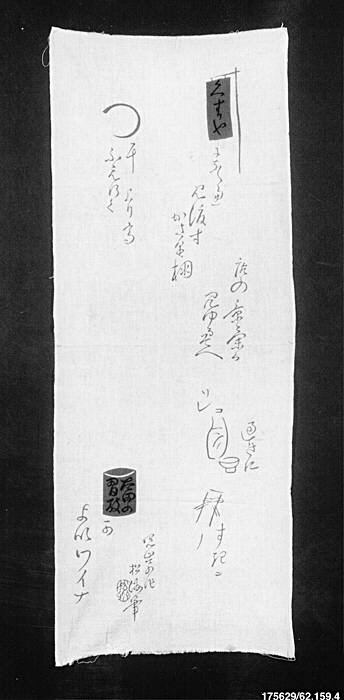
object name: strip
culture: japanese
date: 1901-1950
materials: cotton